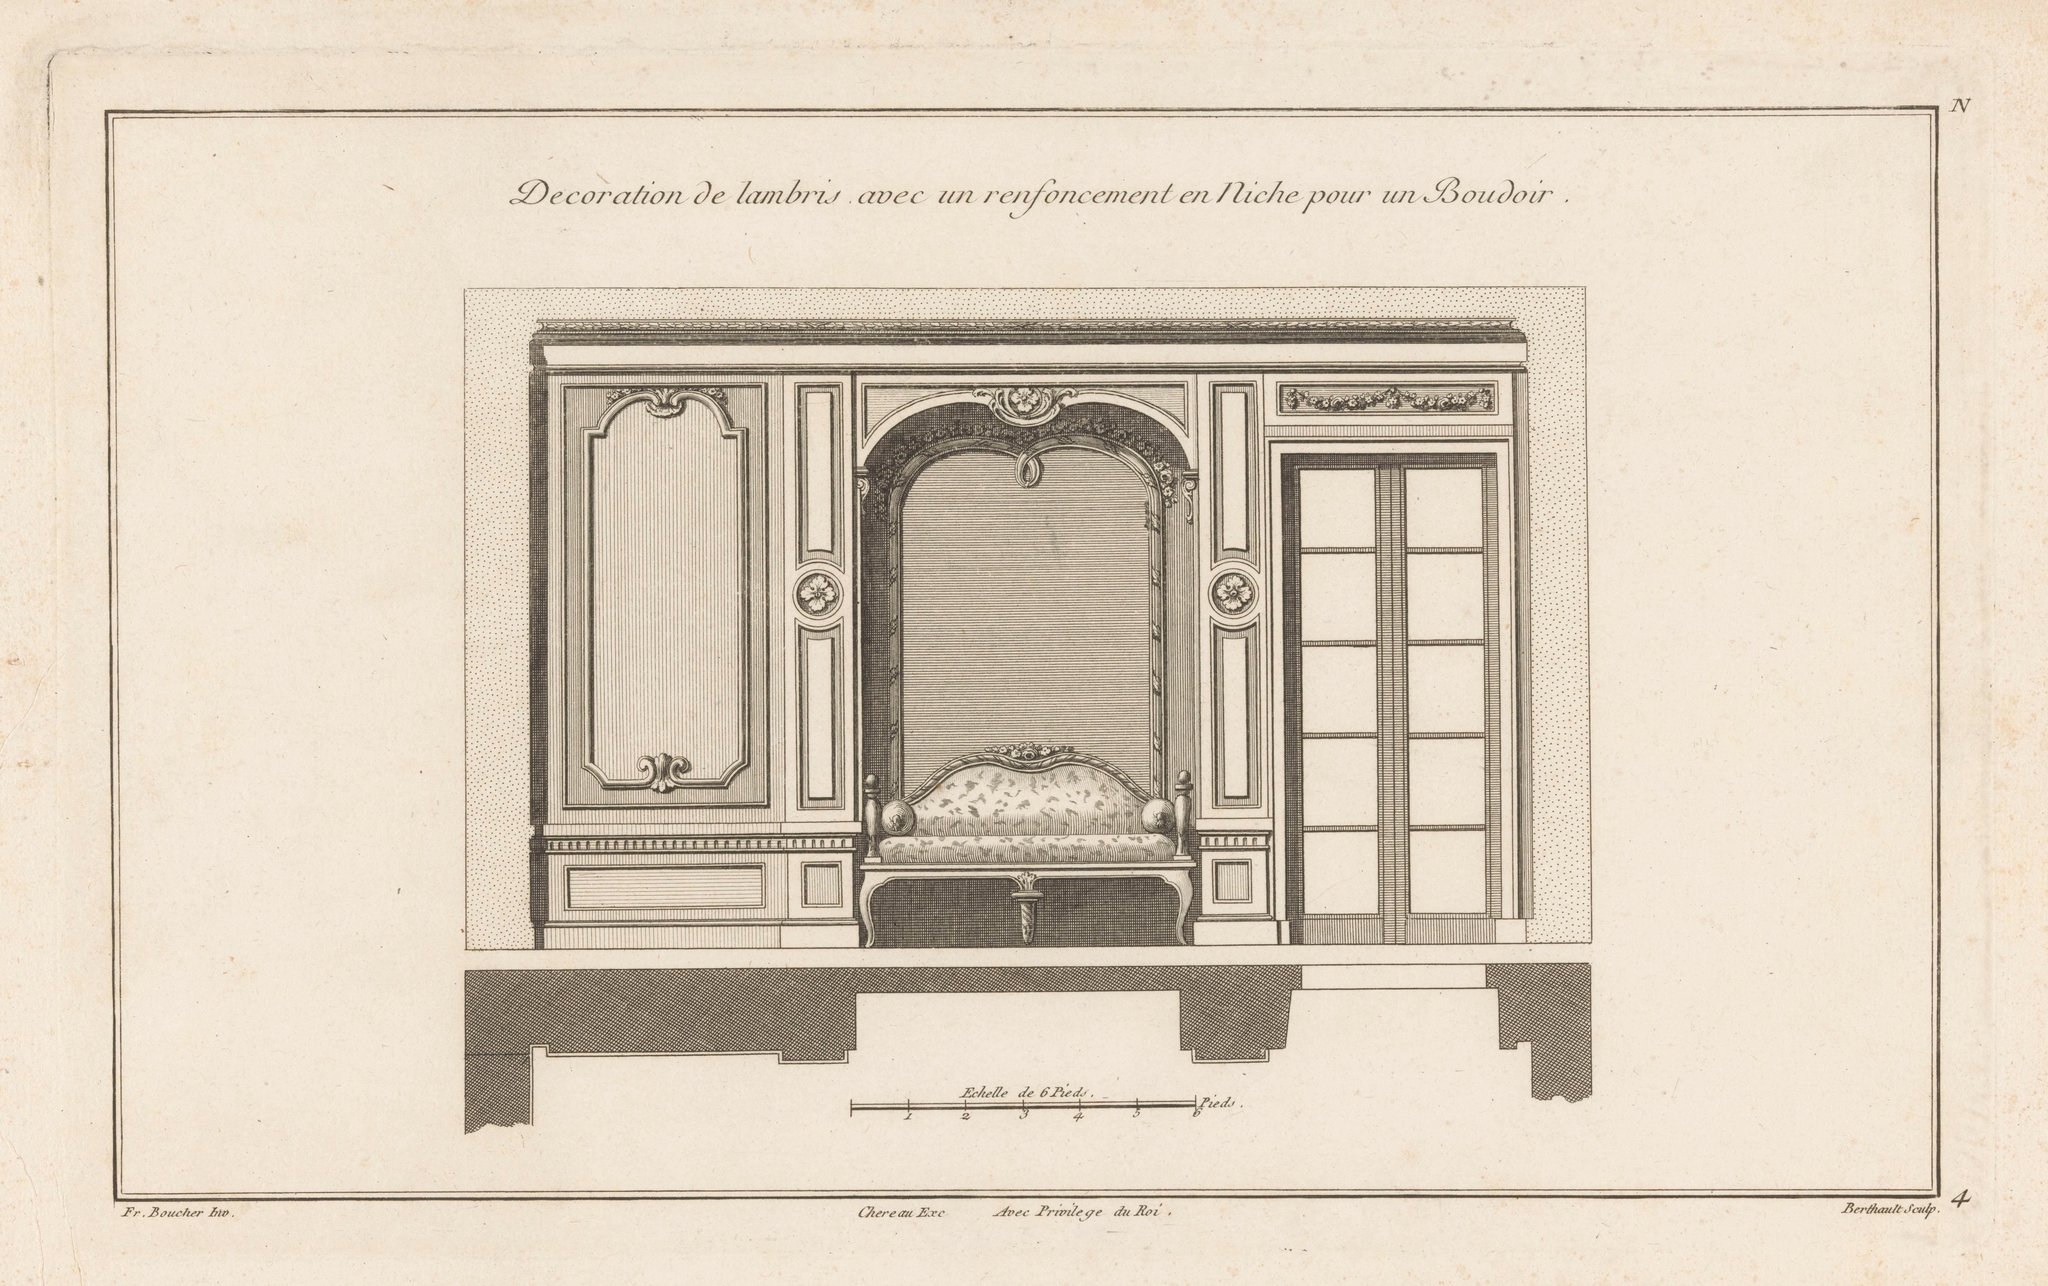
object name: print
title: N Kamerinrichtingen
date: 1752-1794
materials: paper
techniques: engraving, etching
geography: paris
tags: bench, window, panelling, boudoir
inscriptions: collector's mark: Lugt 2228, collector's mark: Lugt 2760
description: Een boudoir met panelen en rechts een venster, in het midden staat een bank in een nis.